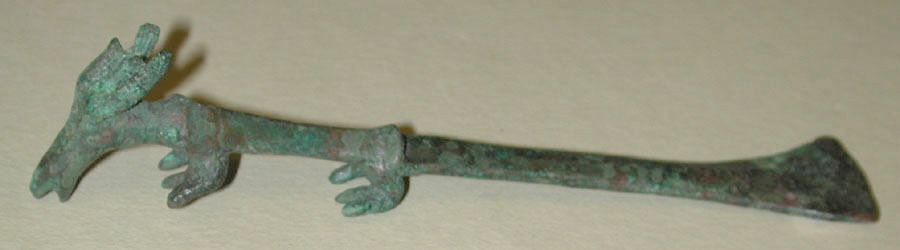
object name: spatula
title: Lime Spatula with Animal Head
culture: indonesian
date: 500 BCE-300 CE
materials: bronze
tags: animals